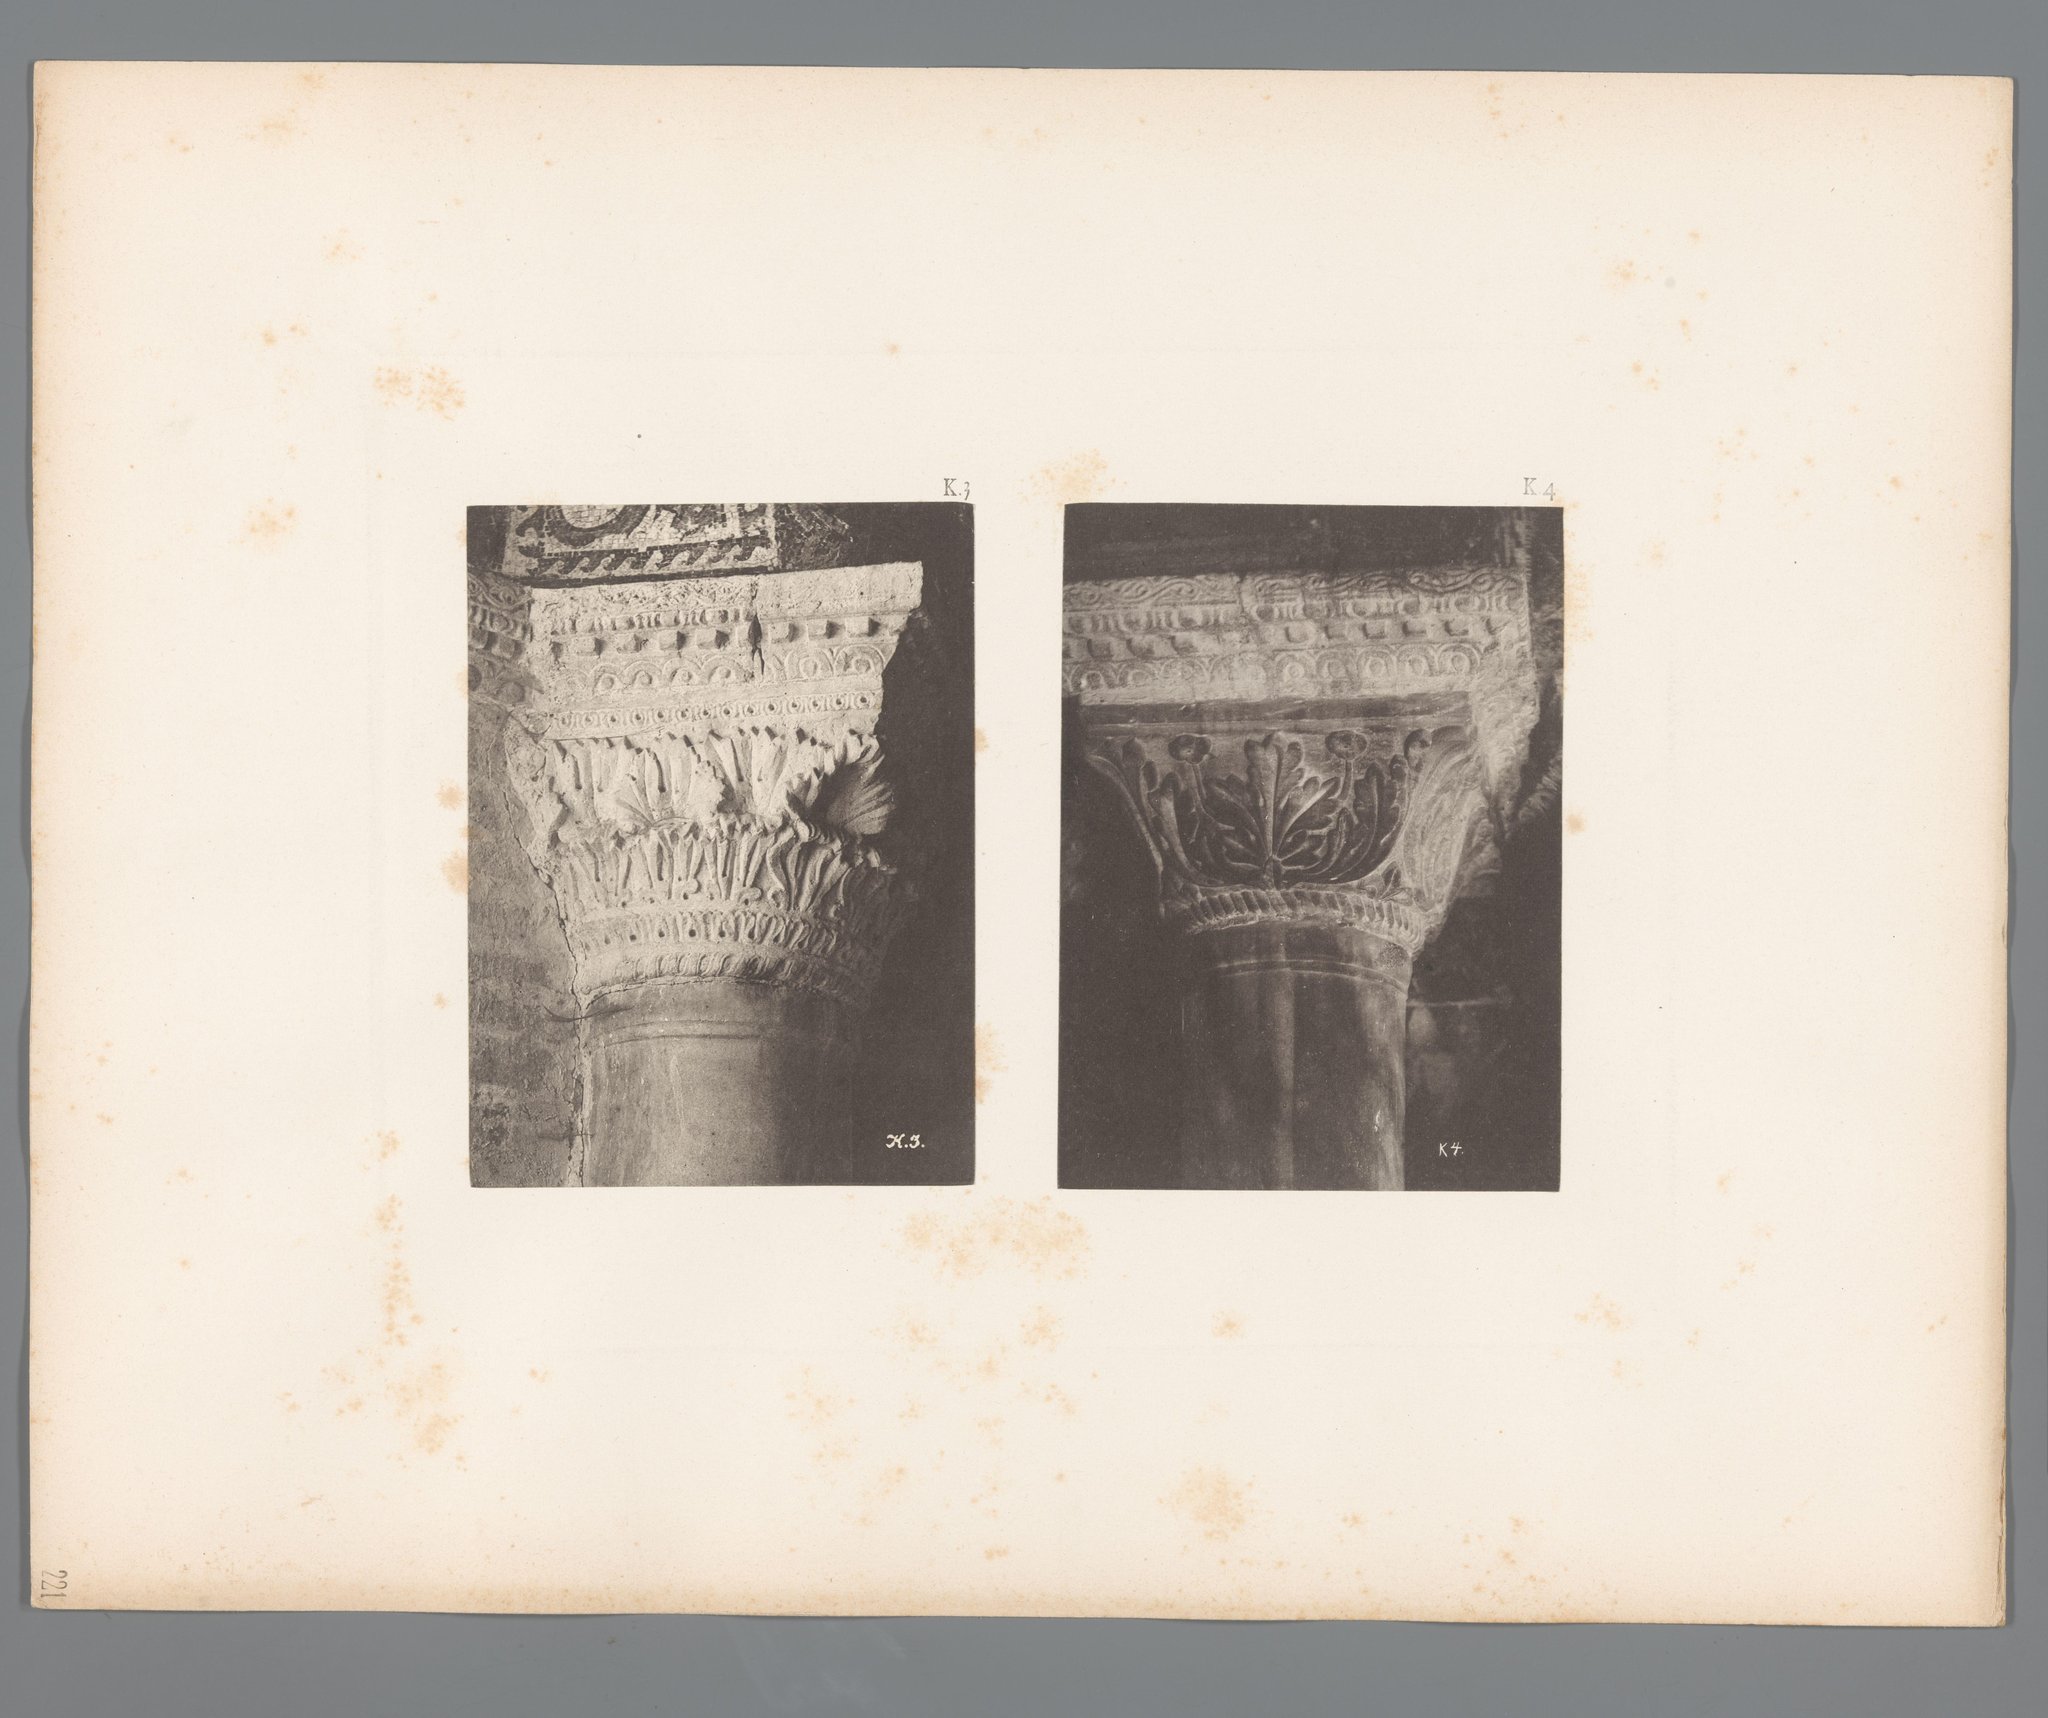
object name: photomechanical print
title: Twee afbeeldingen van kapitelen van de San Marco in Venetië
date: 1880-1885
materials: paper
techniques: photograph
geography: venice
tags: capital (~ column, pillar) (+ styles in art ~ ancient historical period), church (exterior)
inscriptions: number: ‘K.3’, number: ‘K.4’, number: ‘221’, number: ‘K.3.’, number: ‘K4.’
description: Deze prenten maken deel uit van een omslag met 79 prenten op 53 bladen en 2 tekstbladen.